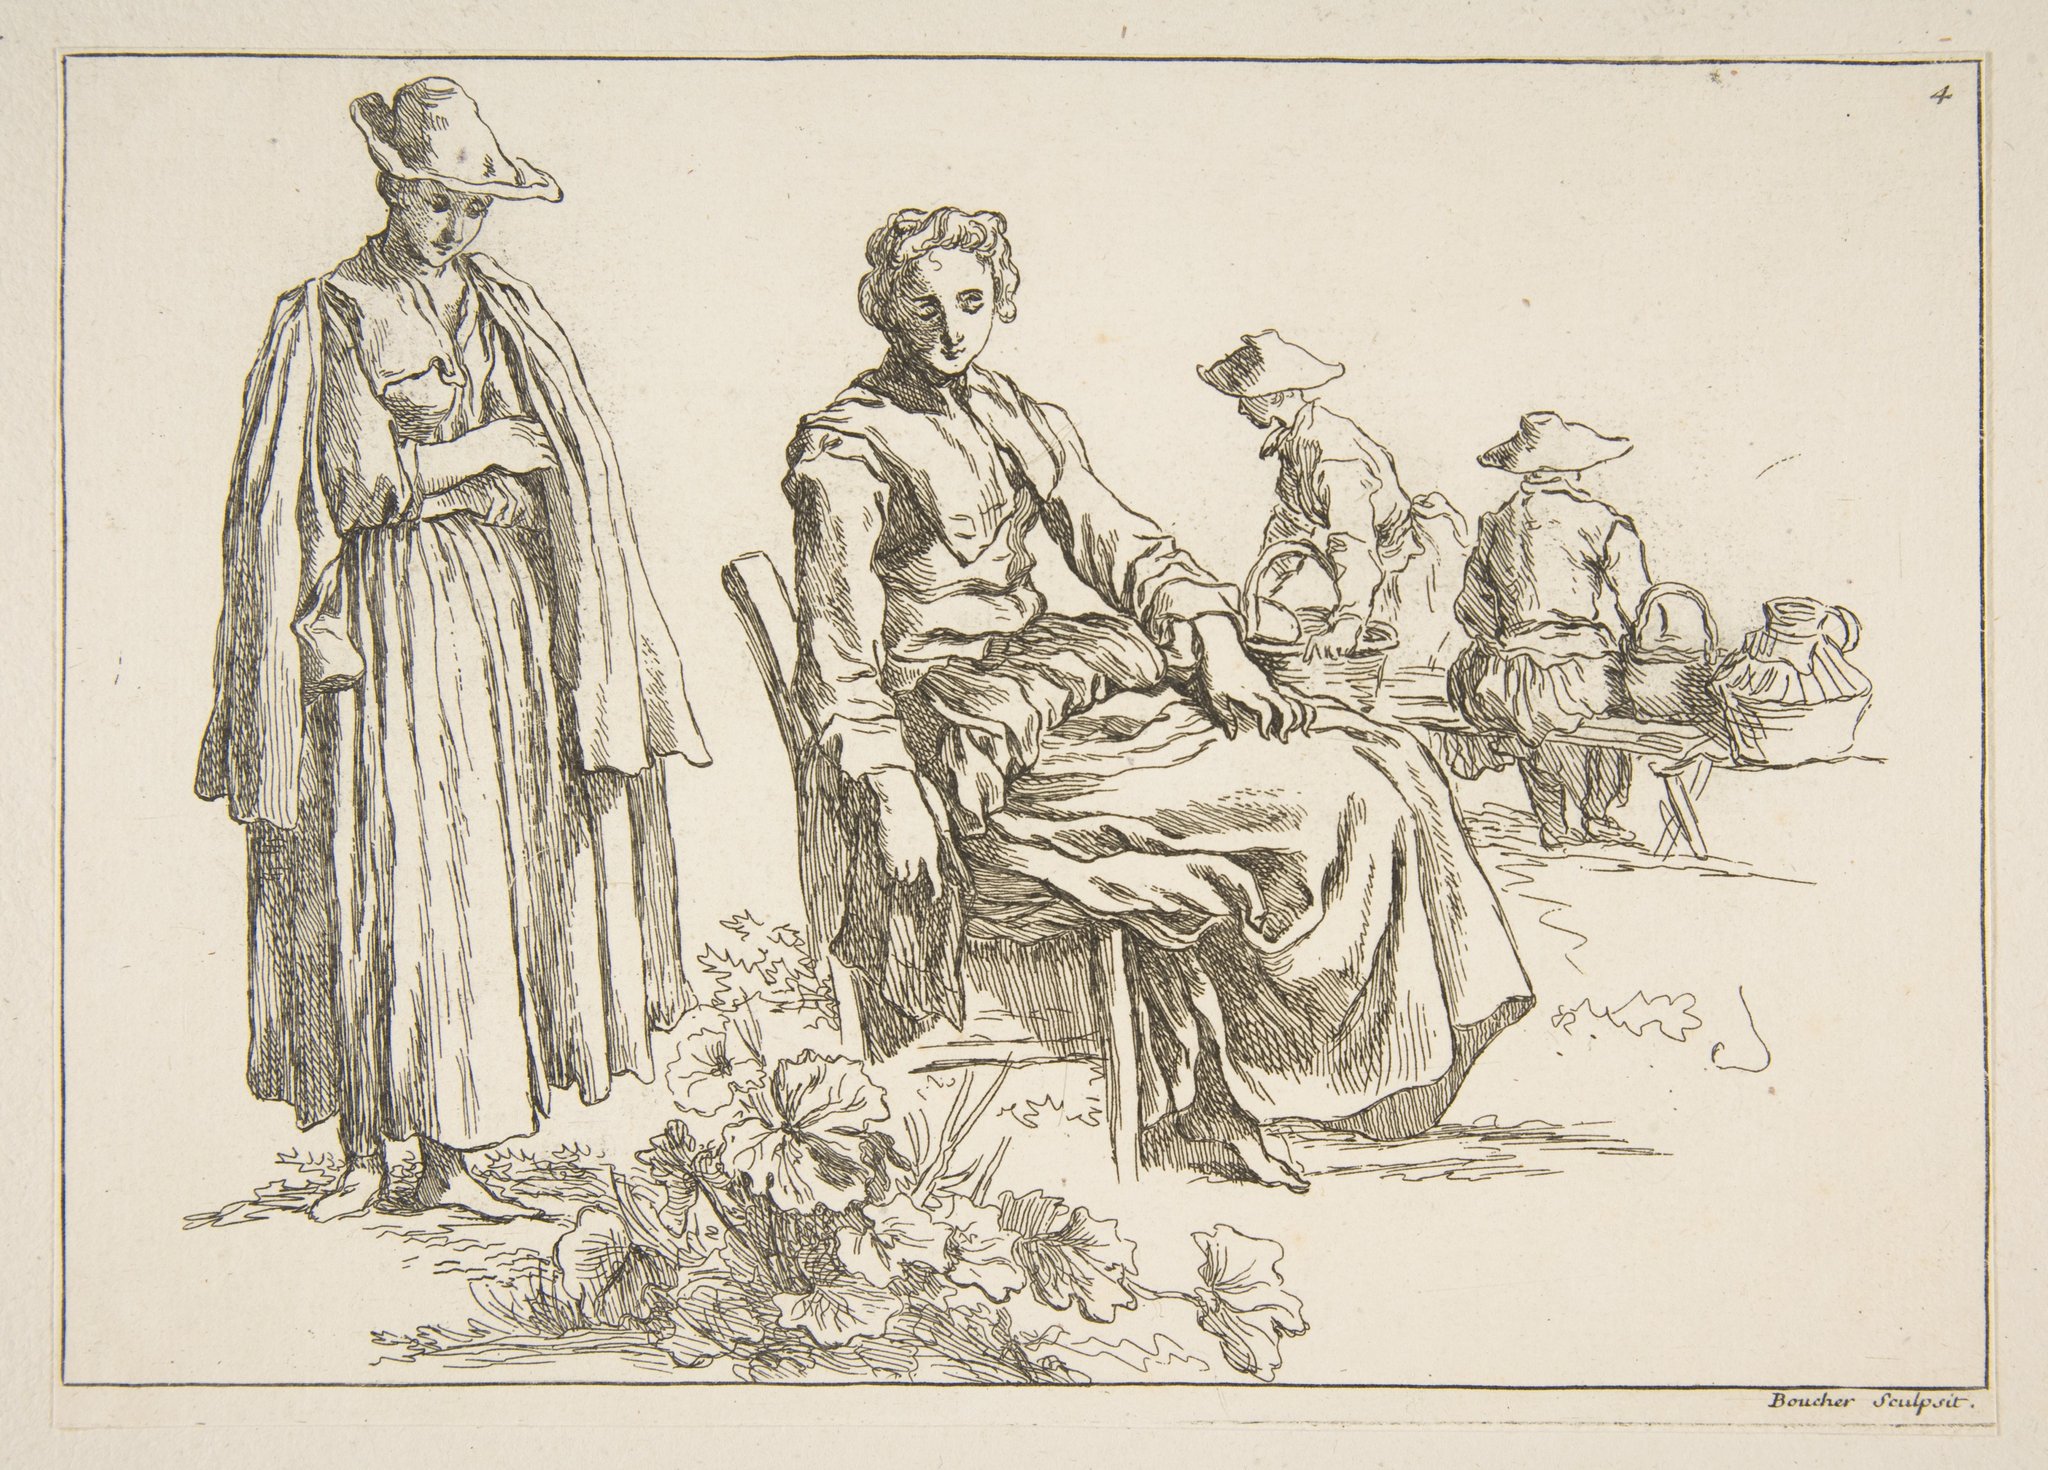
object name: print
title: Sheet of Sketches, from "Livre d’étude d’après les desseins originaux de Blomart"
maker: françois boucher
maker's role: artist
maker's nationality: french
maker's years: 1703-1770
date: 1735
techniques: etching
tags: women,leaves